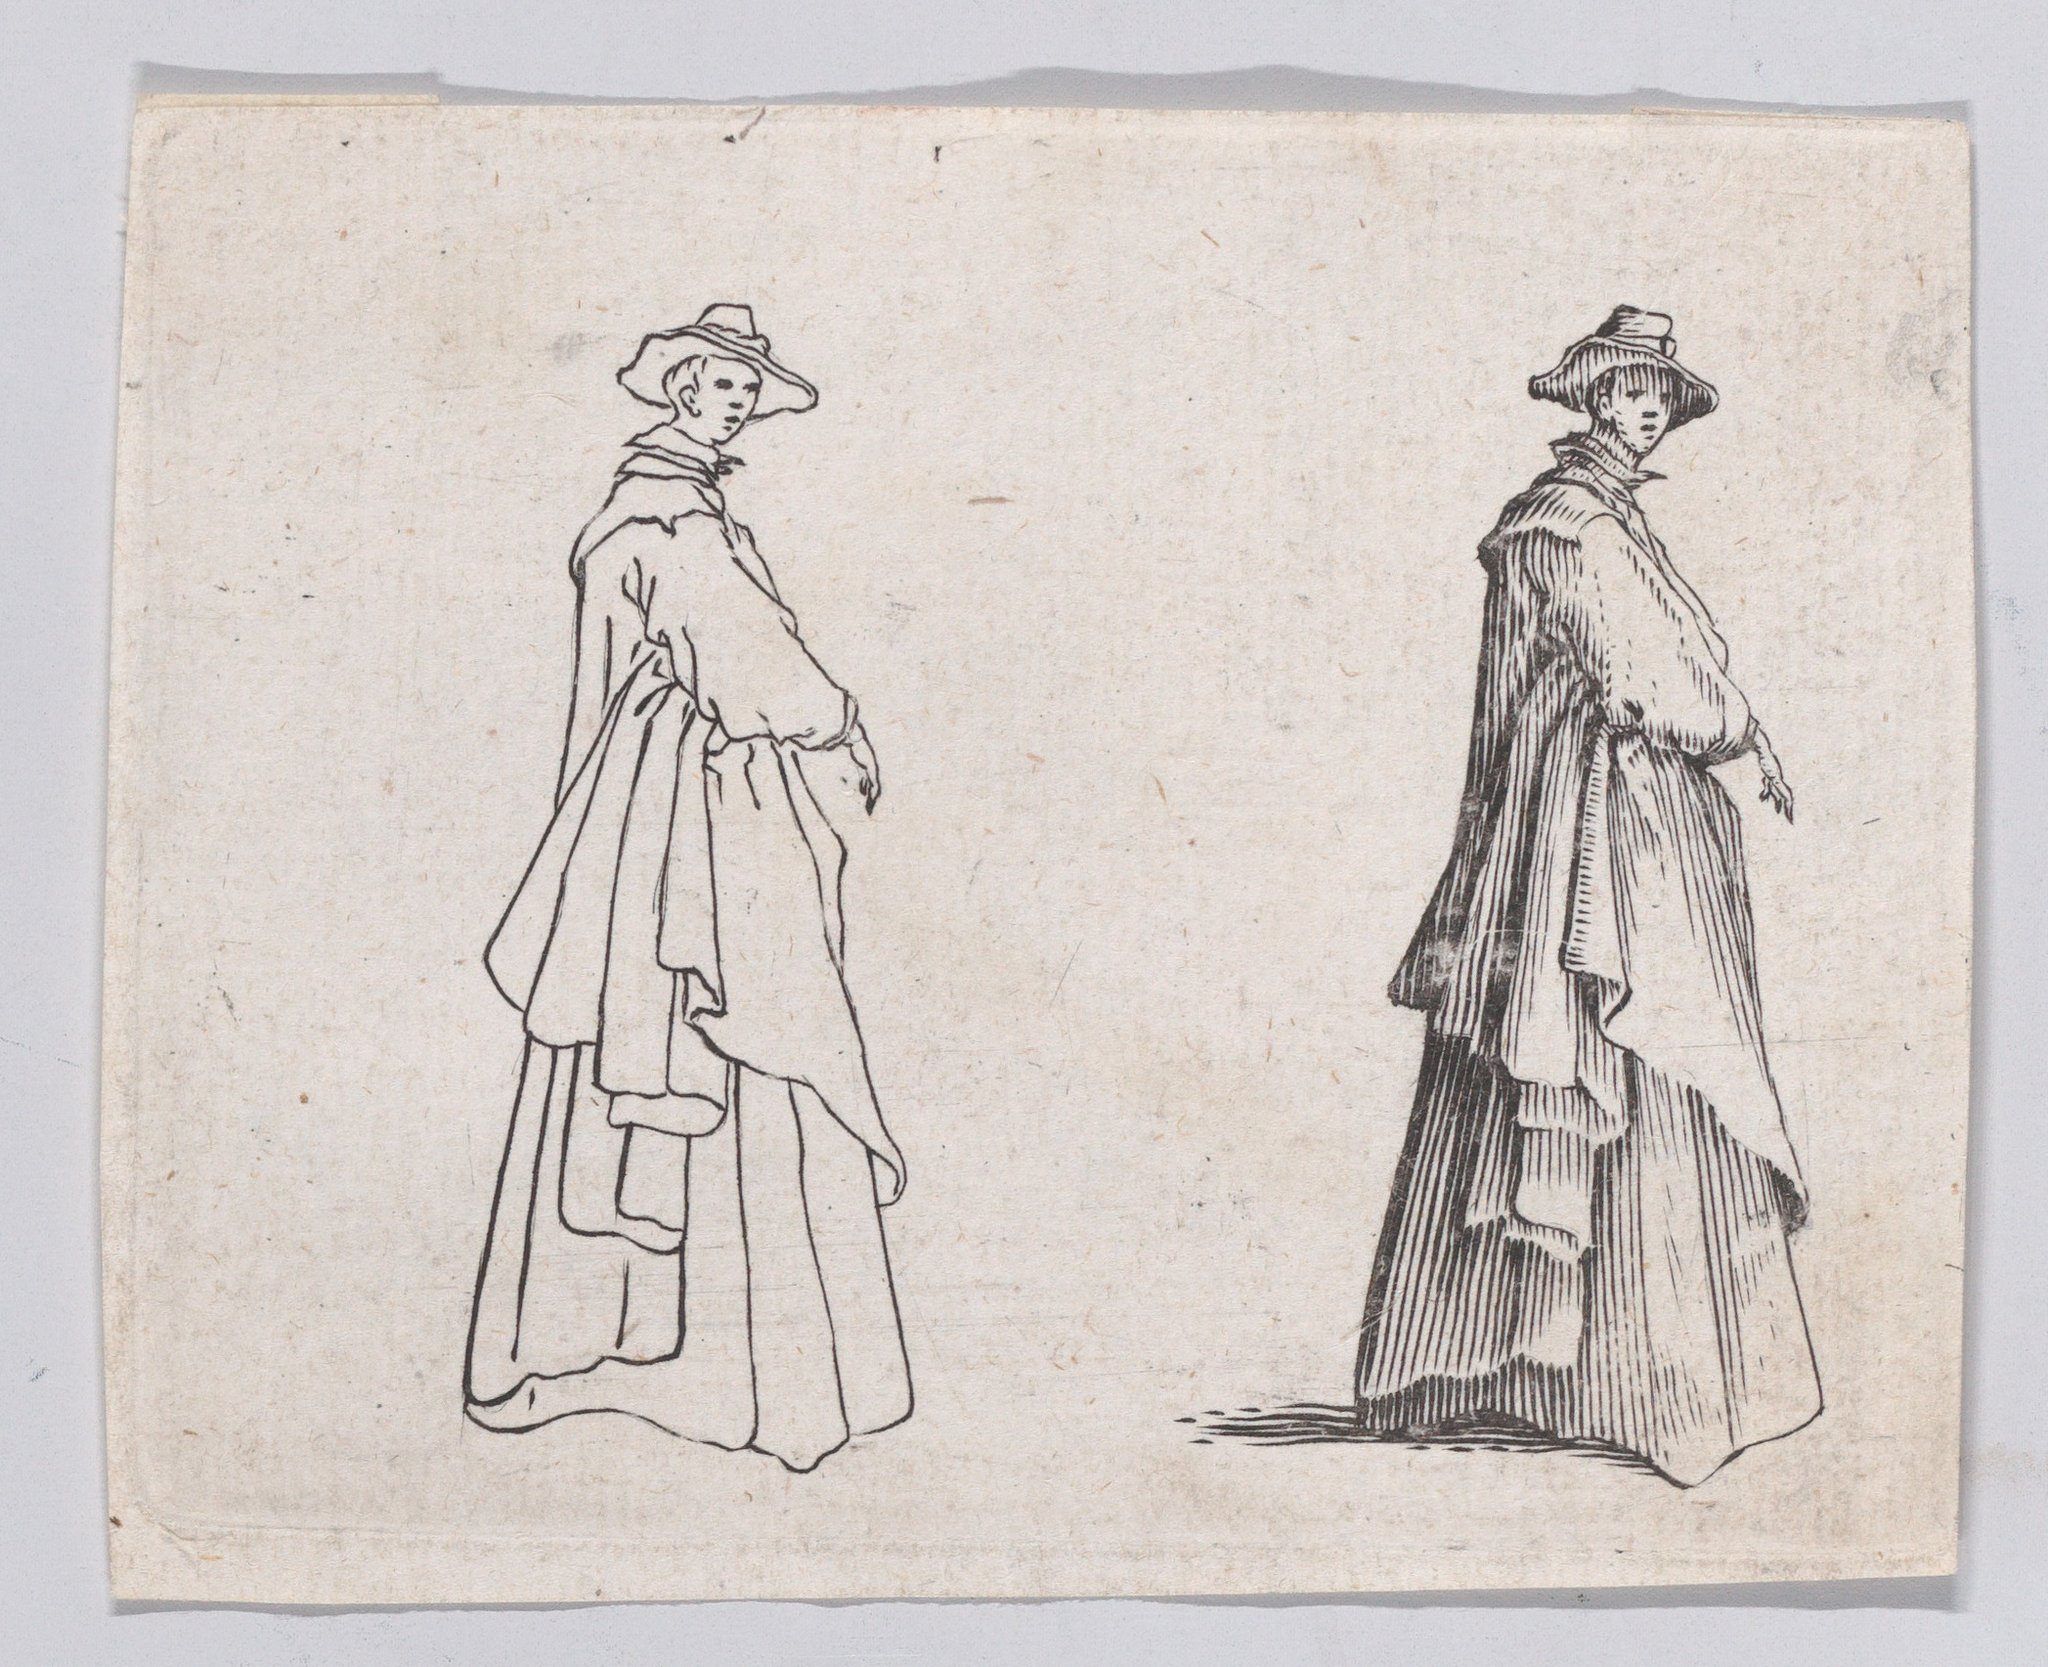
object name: print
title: Reverse Copy of La Dame au Vêtement Ample (The Woman with the Ample Clothing), from "Les Caprices" Series A, The Florence Set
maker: Anonymous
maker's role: artist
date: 1601-1700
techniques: etching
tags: women